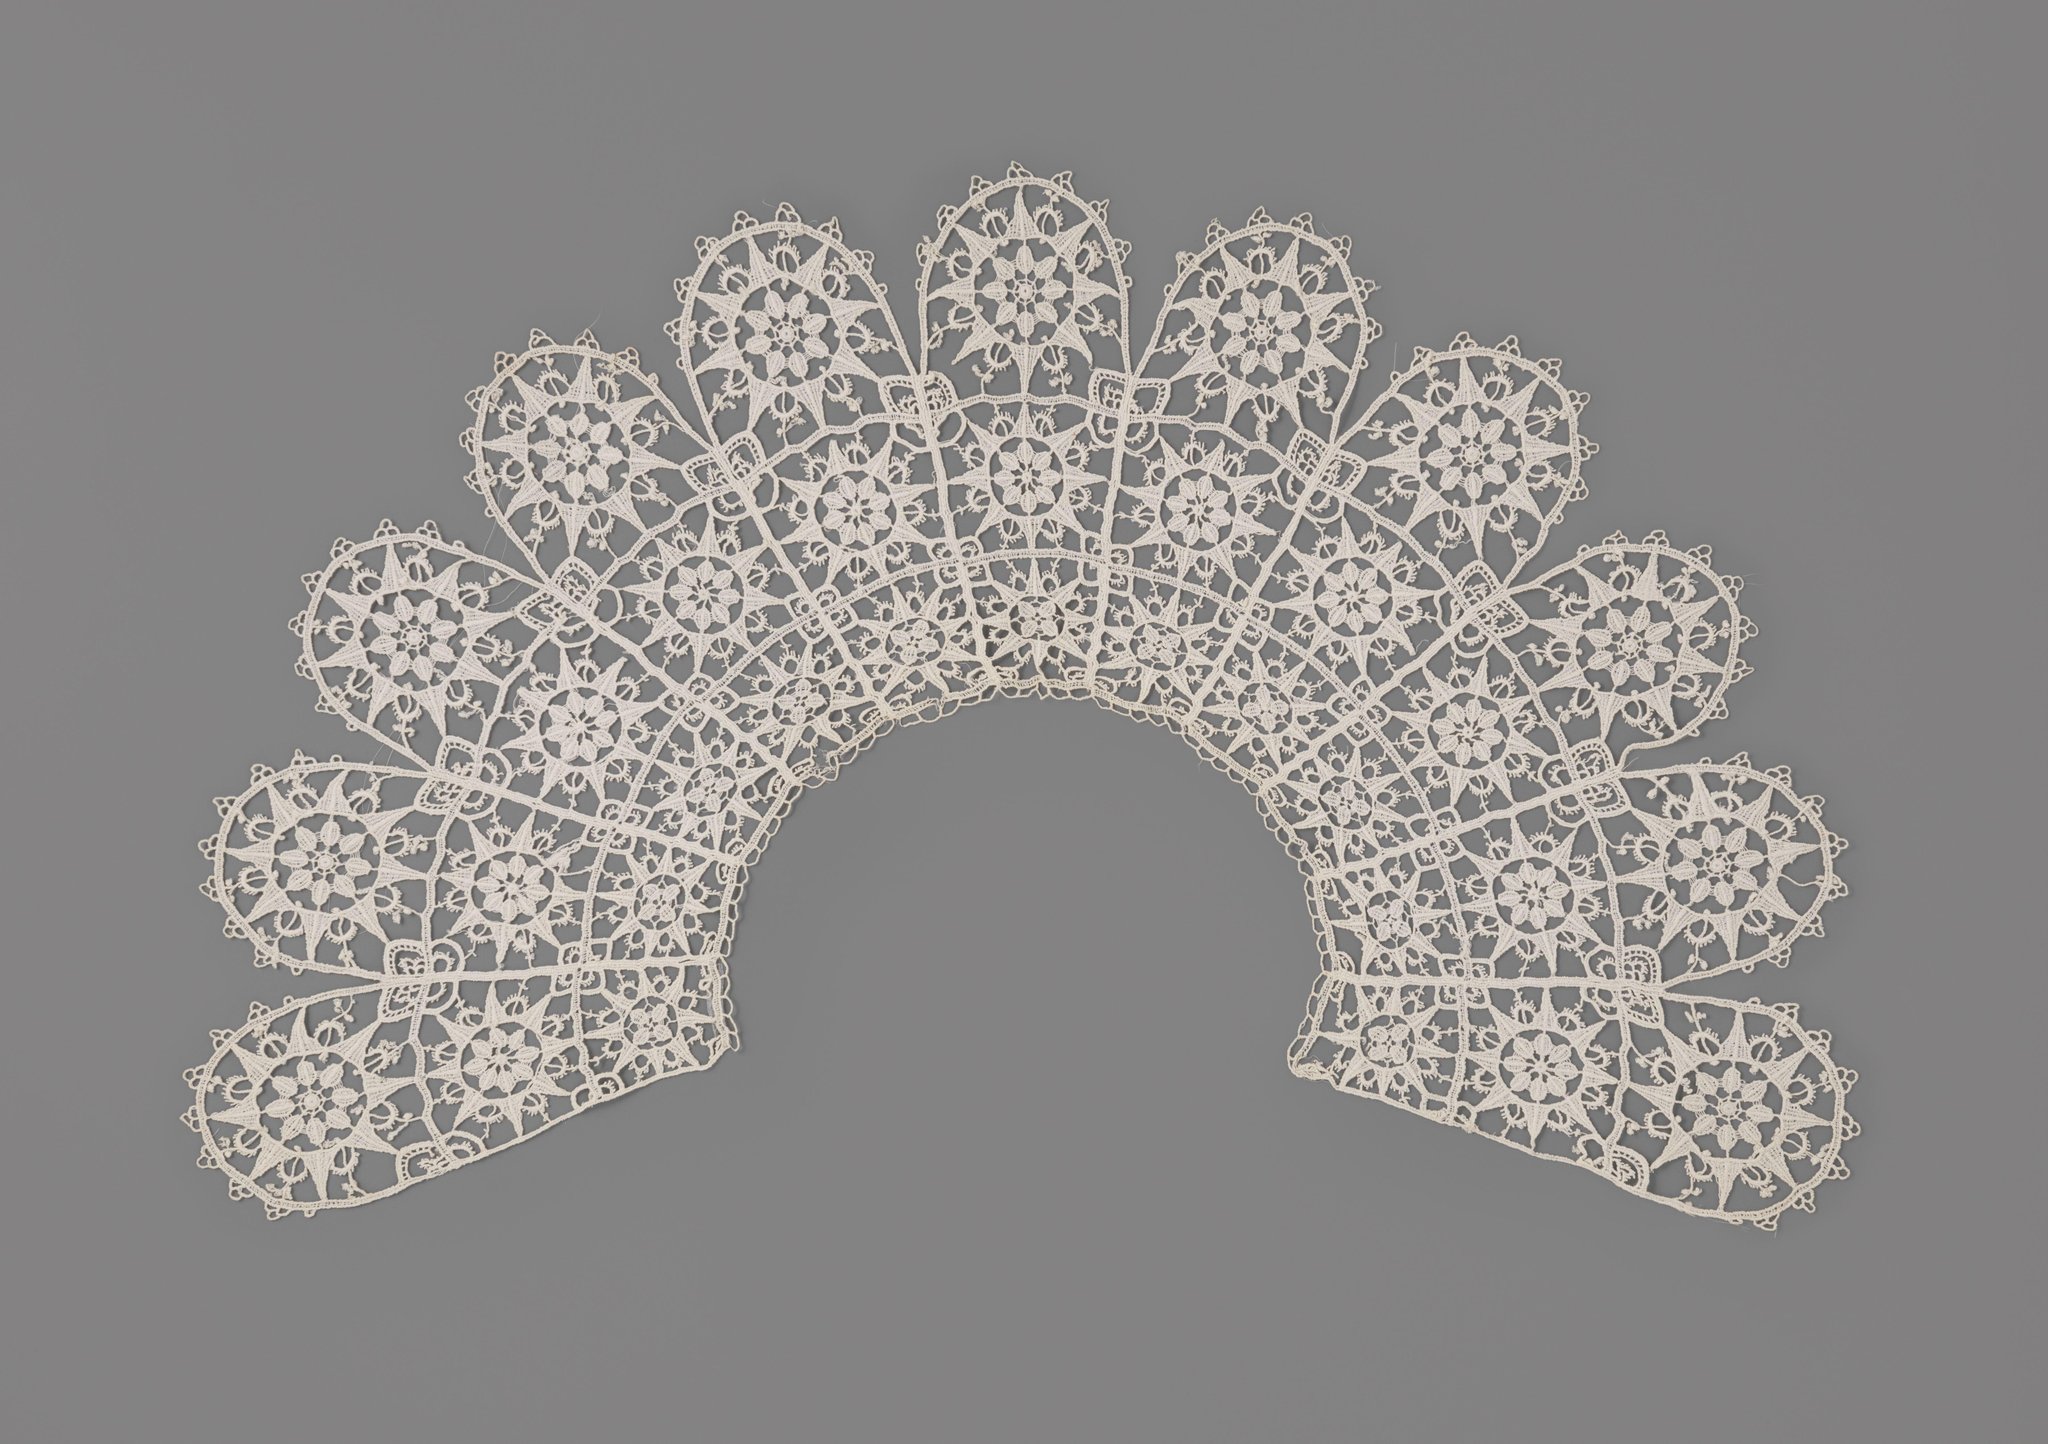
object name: womenswear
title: Kraag van etskant met stervormen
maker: Anonymous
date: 1910-1915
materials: cotton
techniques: lace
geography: sankt gallen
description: Kraag van naturelkleurige machinale kant: etskant. Het kant imiteert reticella. De kraag heeft elf schulpen en is gedecoreerd met stervormen.